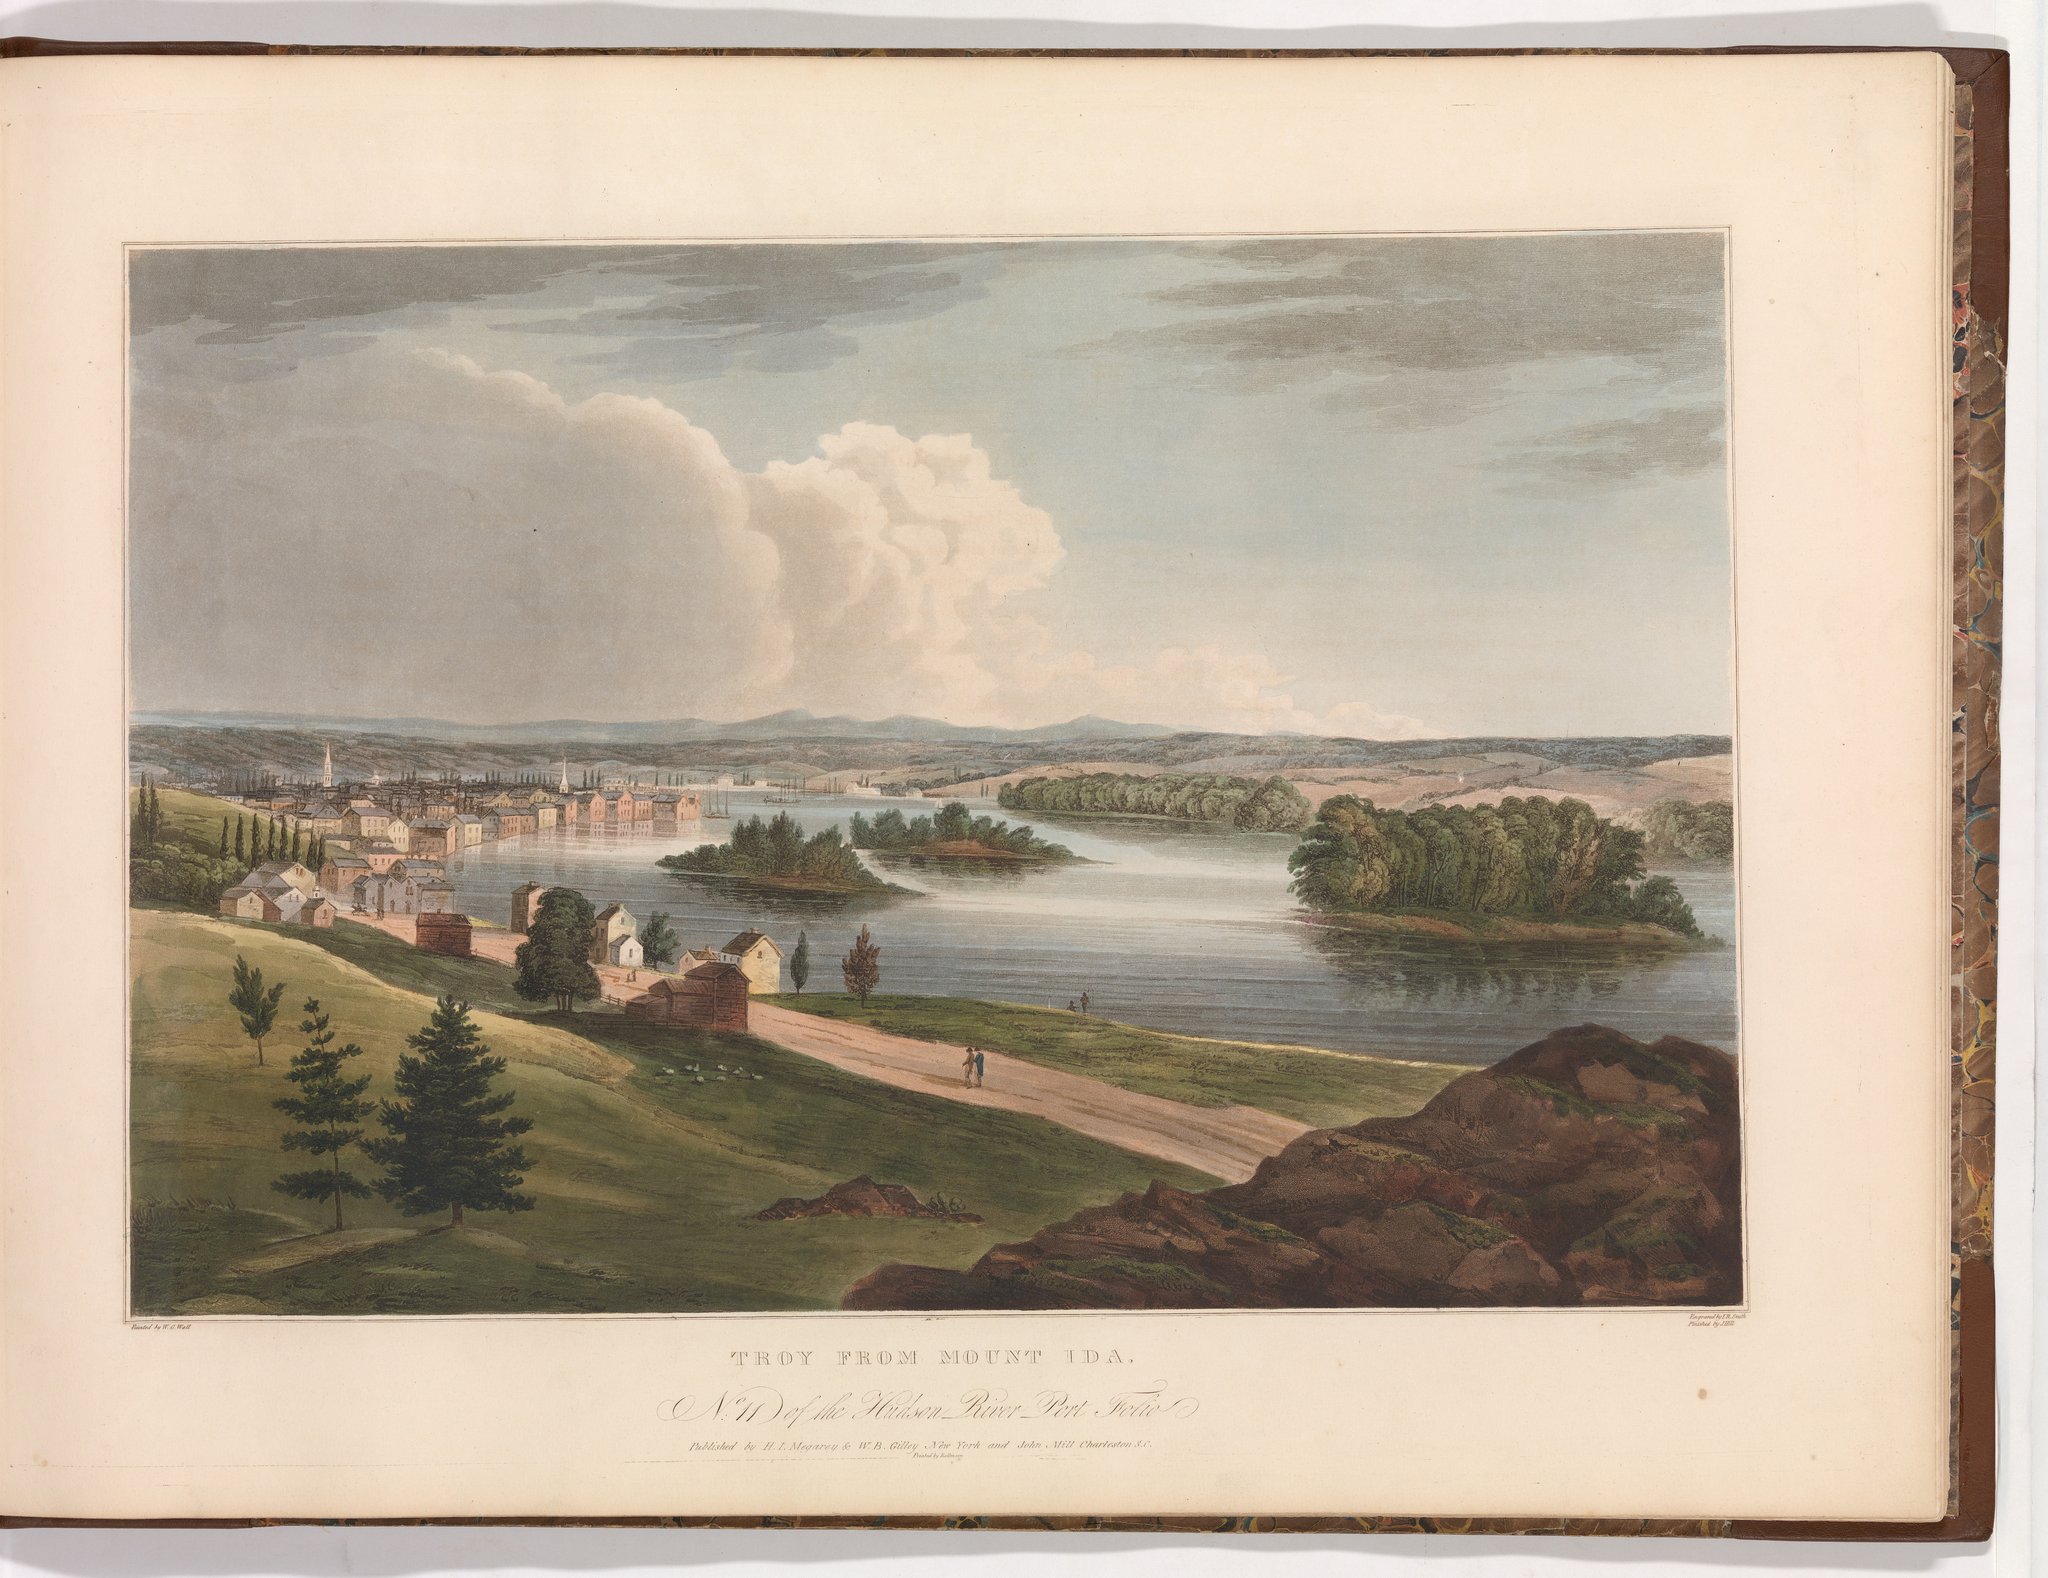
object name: print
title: Troy from Mount Ida (No. 11 of The Hudson River Portfolio)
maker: john rubens smith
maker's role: etcher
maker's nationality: american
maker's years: 1775-1849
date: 1821-1822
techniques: aquatint, hand coloring, printing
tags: landscapes